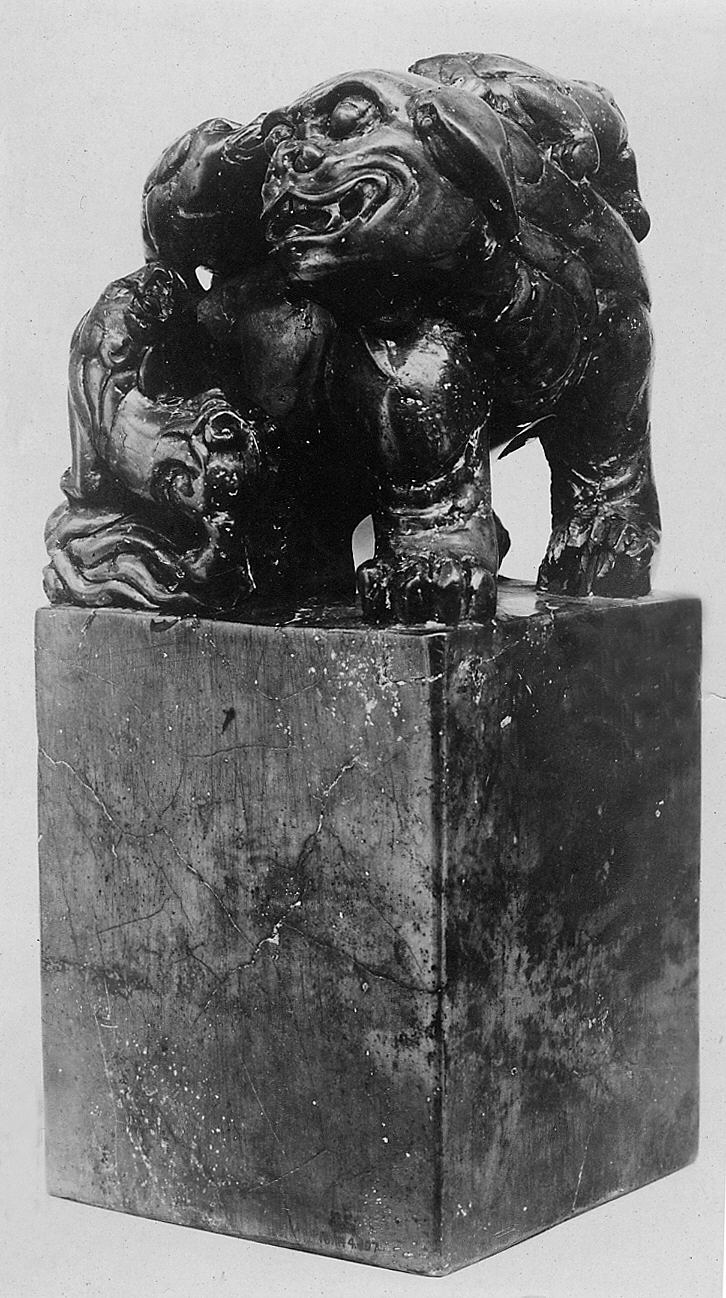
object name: seal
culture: chinese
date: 1368-1644